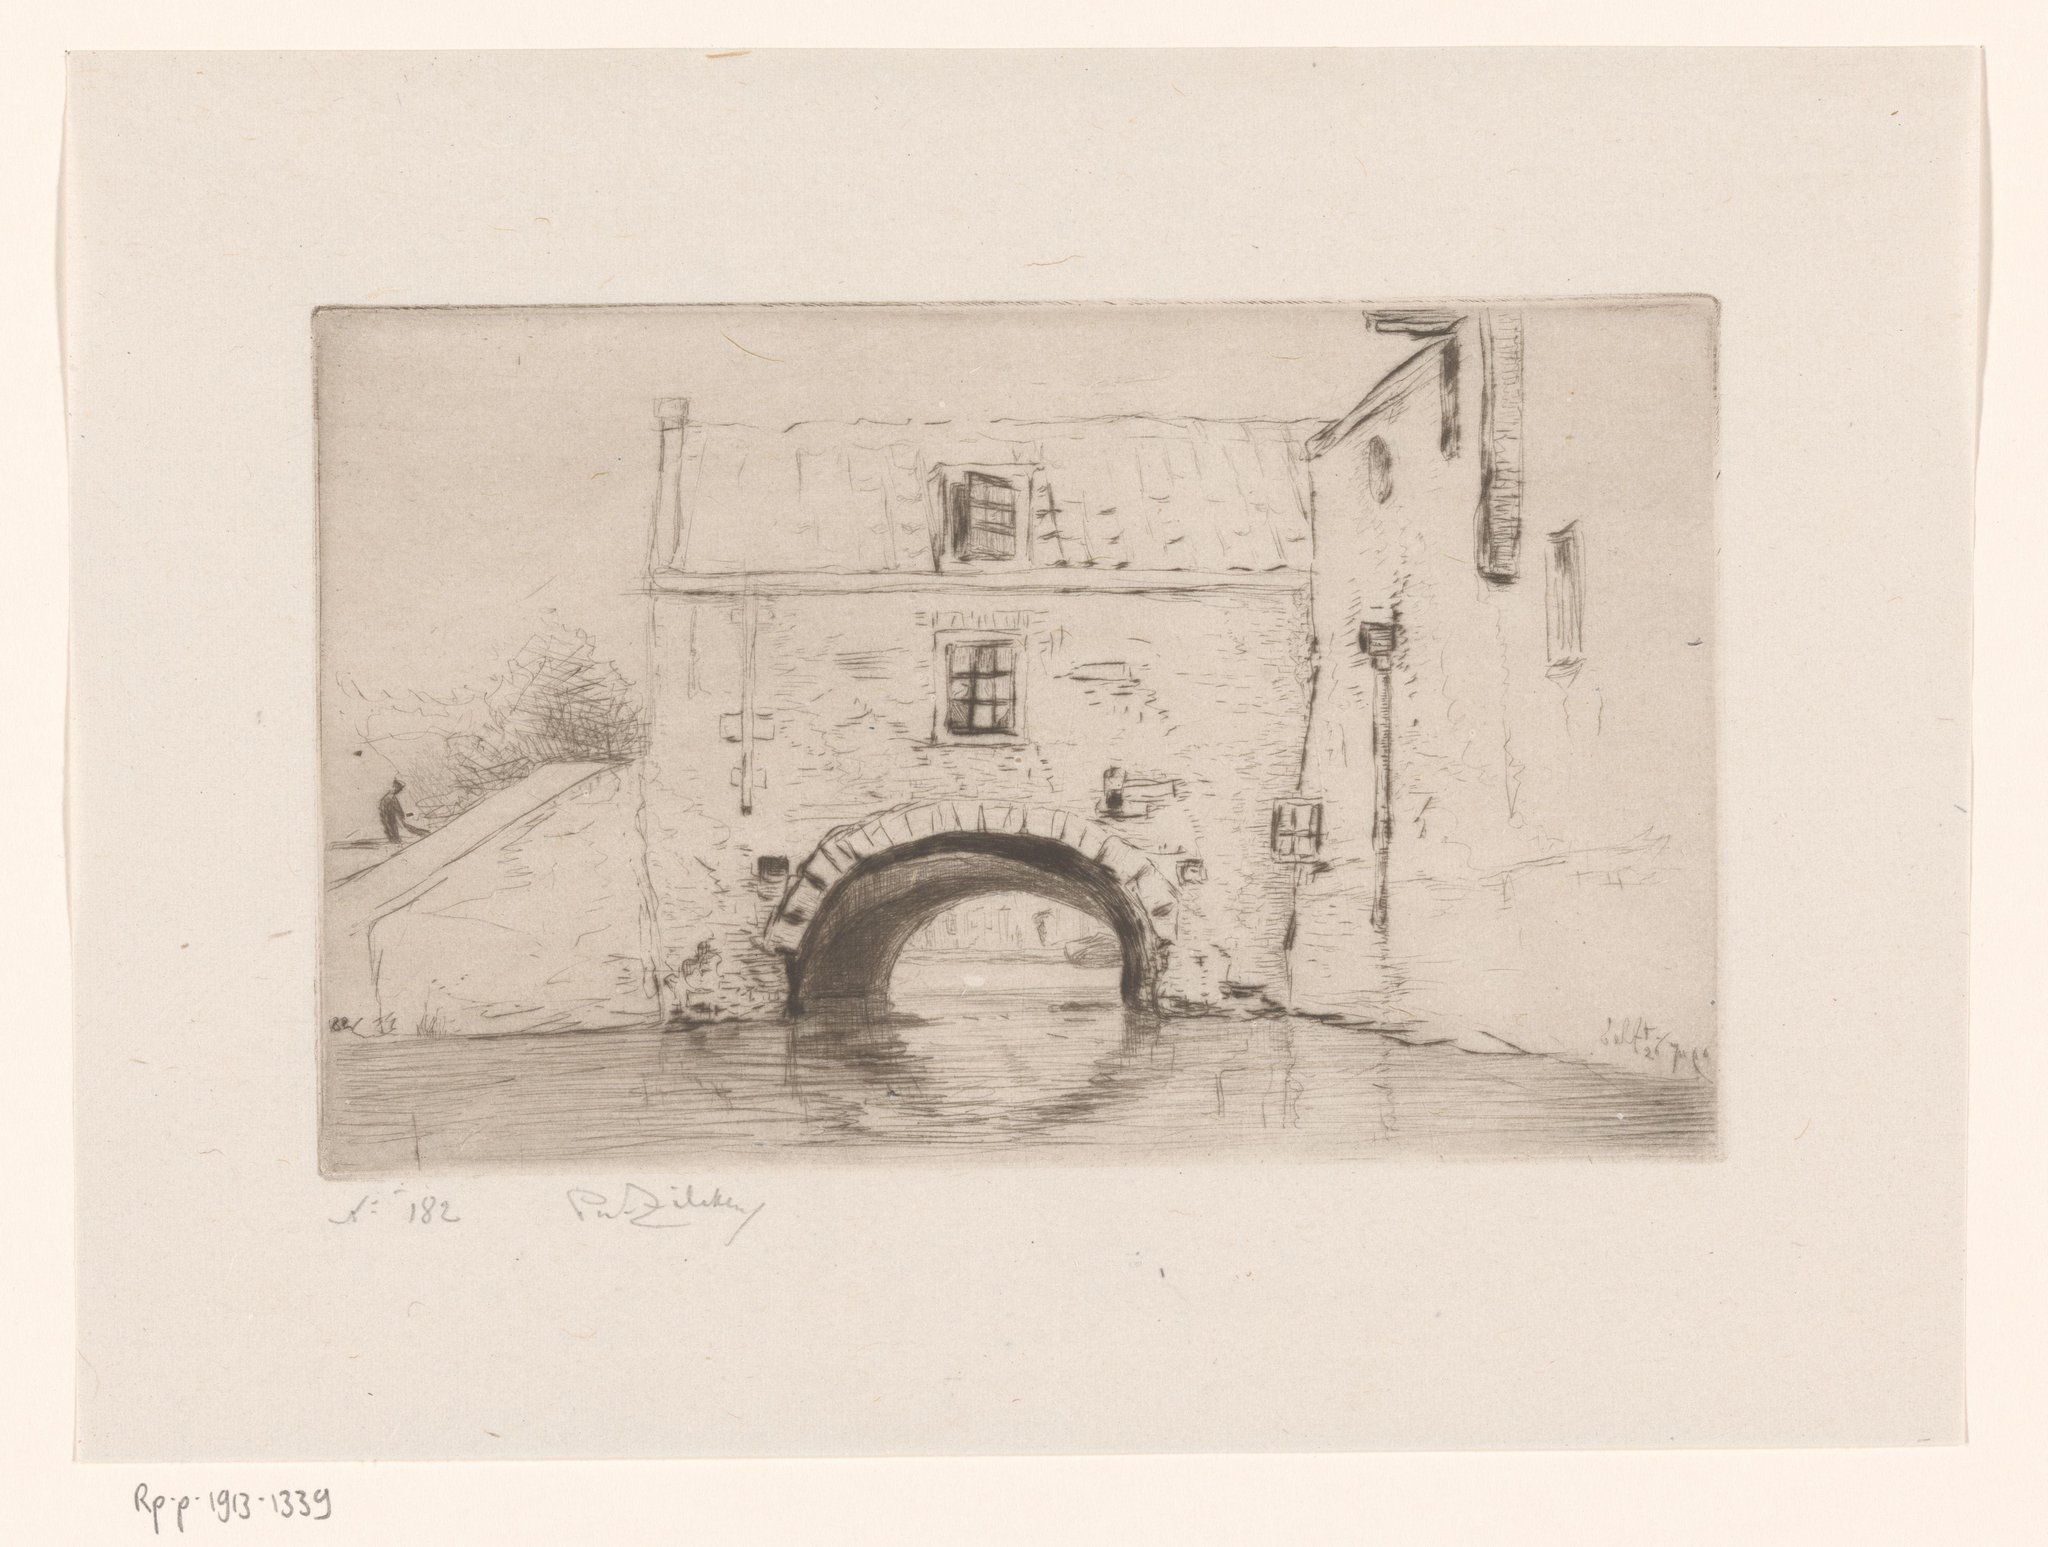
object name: print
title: A côte de la Oostpoort, a Delft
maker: philip zilcken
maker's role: draughtsman, painter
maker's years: 1857-1930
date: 1890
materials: paper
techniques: drypoint, intaglio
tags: canals, waters (in city), city-gate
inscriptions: collector's mark: Lugt 2233